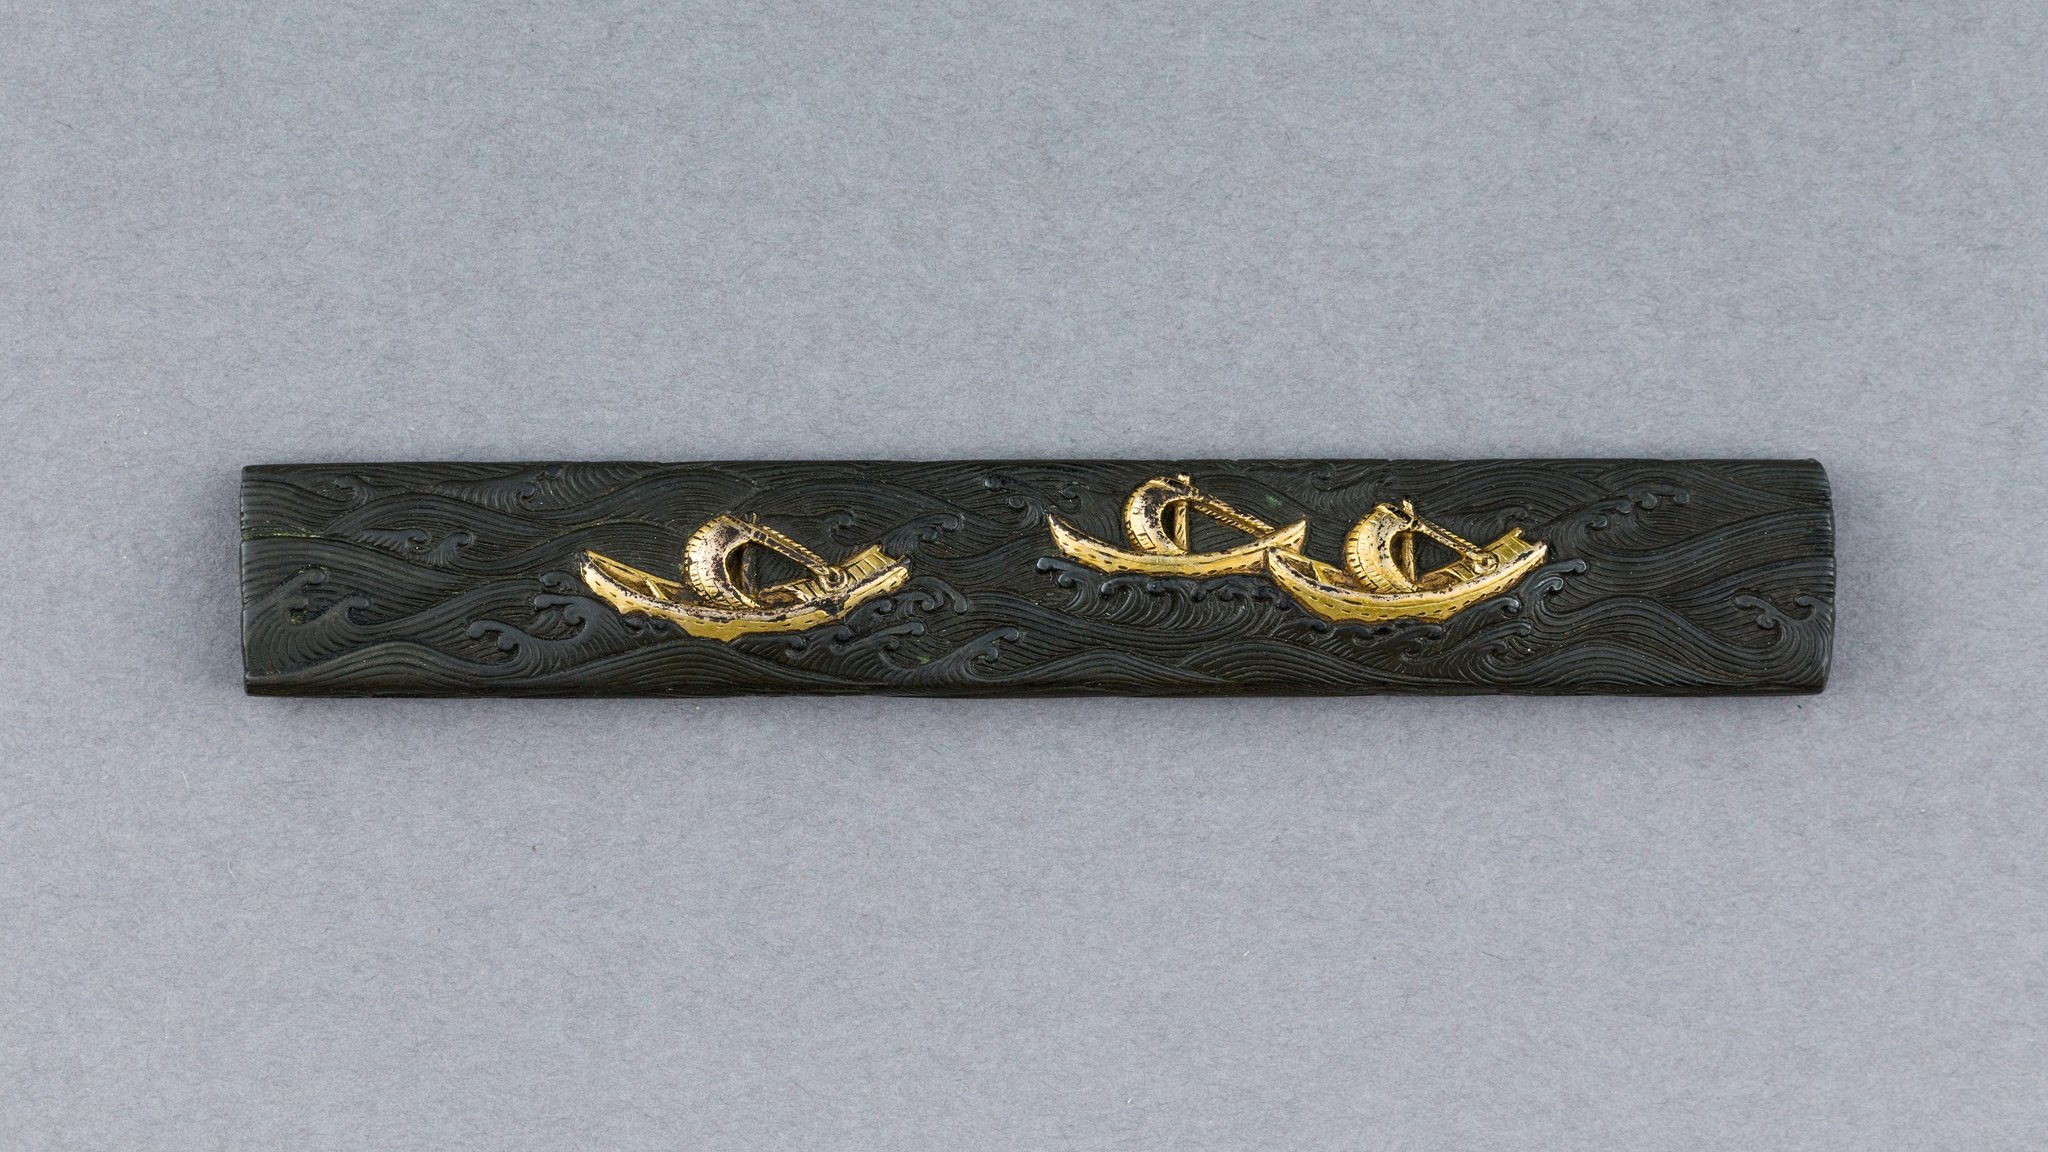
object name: knife handle kozuka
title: Knife Handle (Kozuka)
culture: japanese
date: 1615-1868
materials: gold alloy, gold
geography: japan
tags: boats